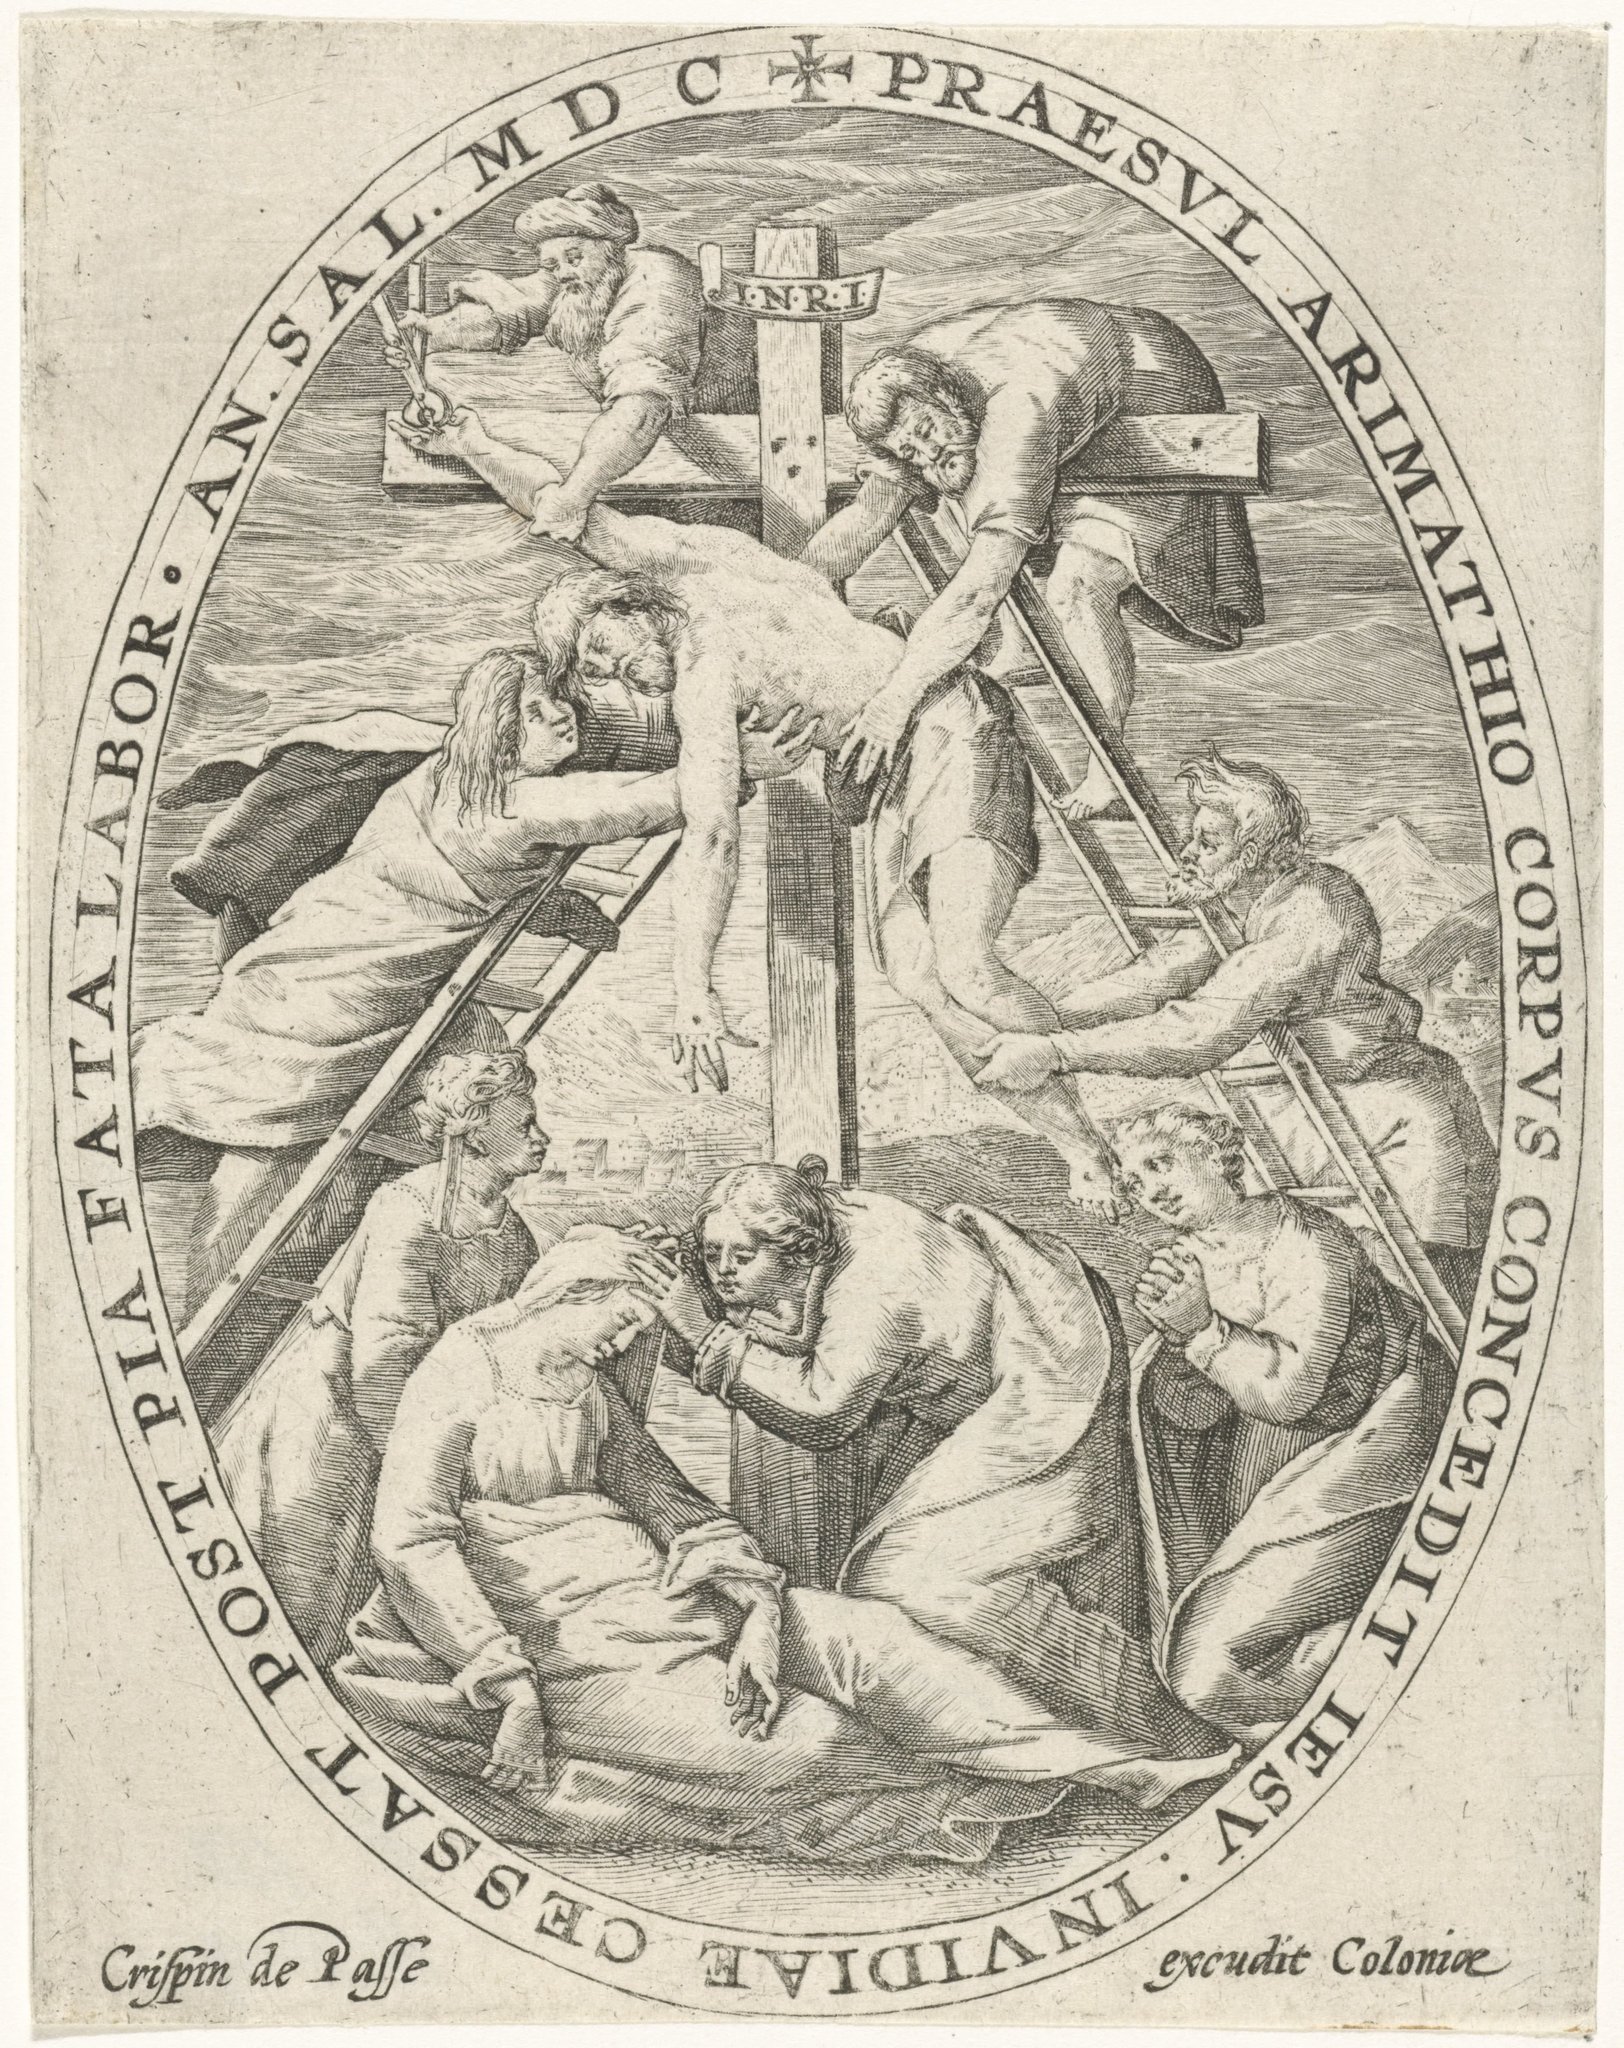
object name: print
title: Passie van Christus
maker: crispijn van de passe (i)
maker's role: draughtsman, print maker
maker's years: 1564-1637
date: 1600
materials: paper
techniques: engraving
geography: cologne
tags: descent from the cross: christ is taken down from the cross, usually by nicodemus and joseph of arimathaea who are standing on the ladders (both arms of christ detached)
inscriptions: collector's mark: Lugt 2542, collector's mark: Lugt 2228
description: Het lichaam van Christus wordt door Nikodemus, Jozef en twee onbekende mannen van het kruis gehaald. Maria, Johannes en Maria Magdalena zitten op de grond en treuren. De voorstelling is gevat in een ovale omlijsting met een randschrift in het Latijn. Prent uit een serie met de passie van Christus.